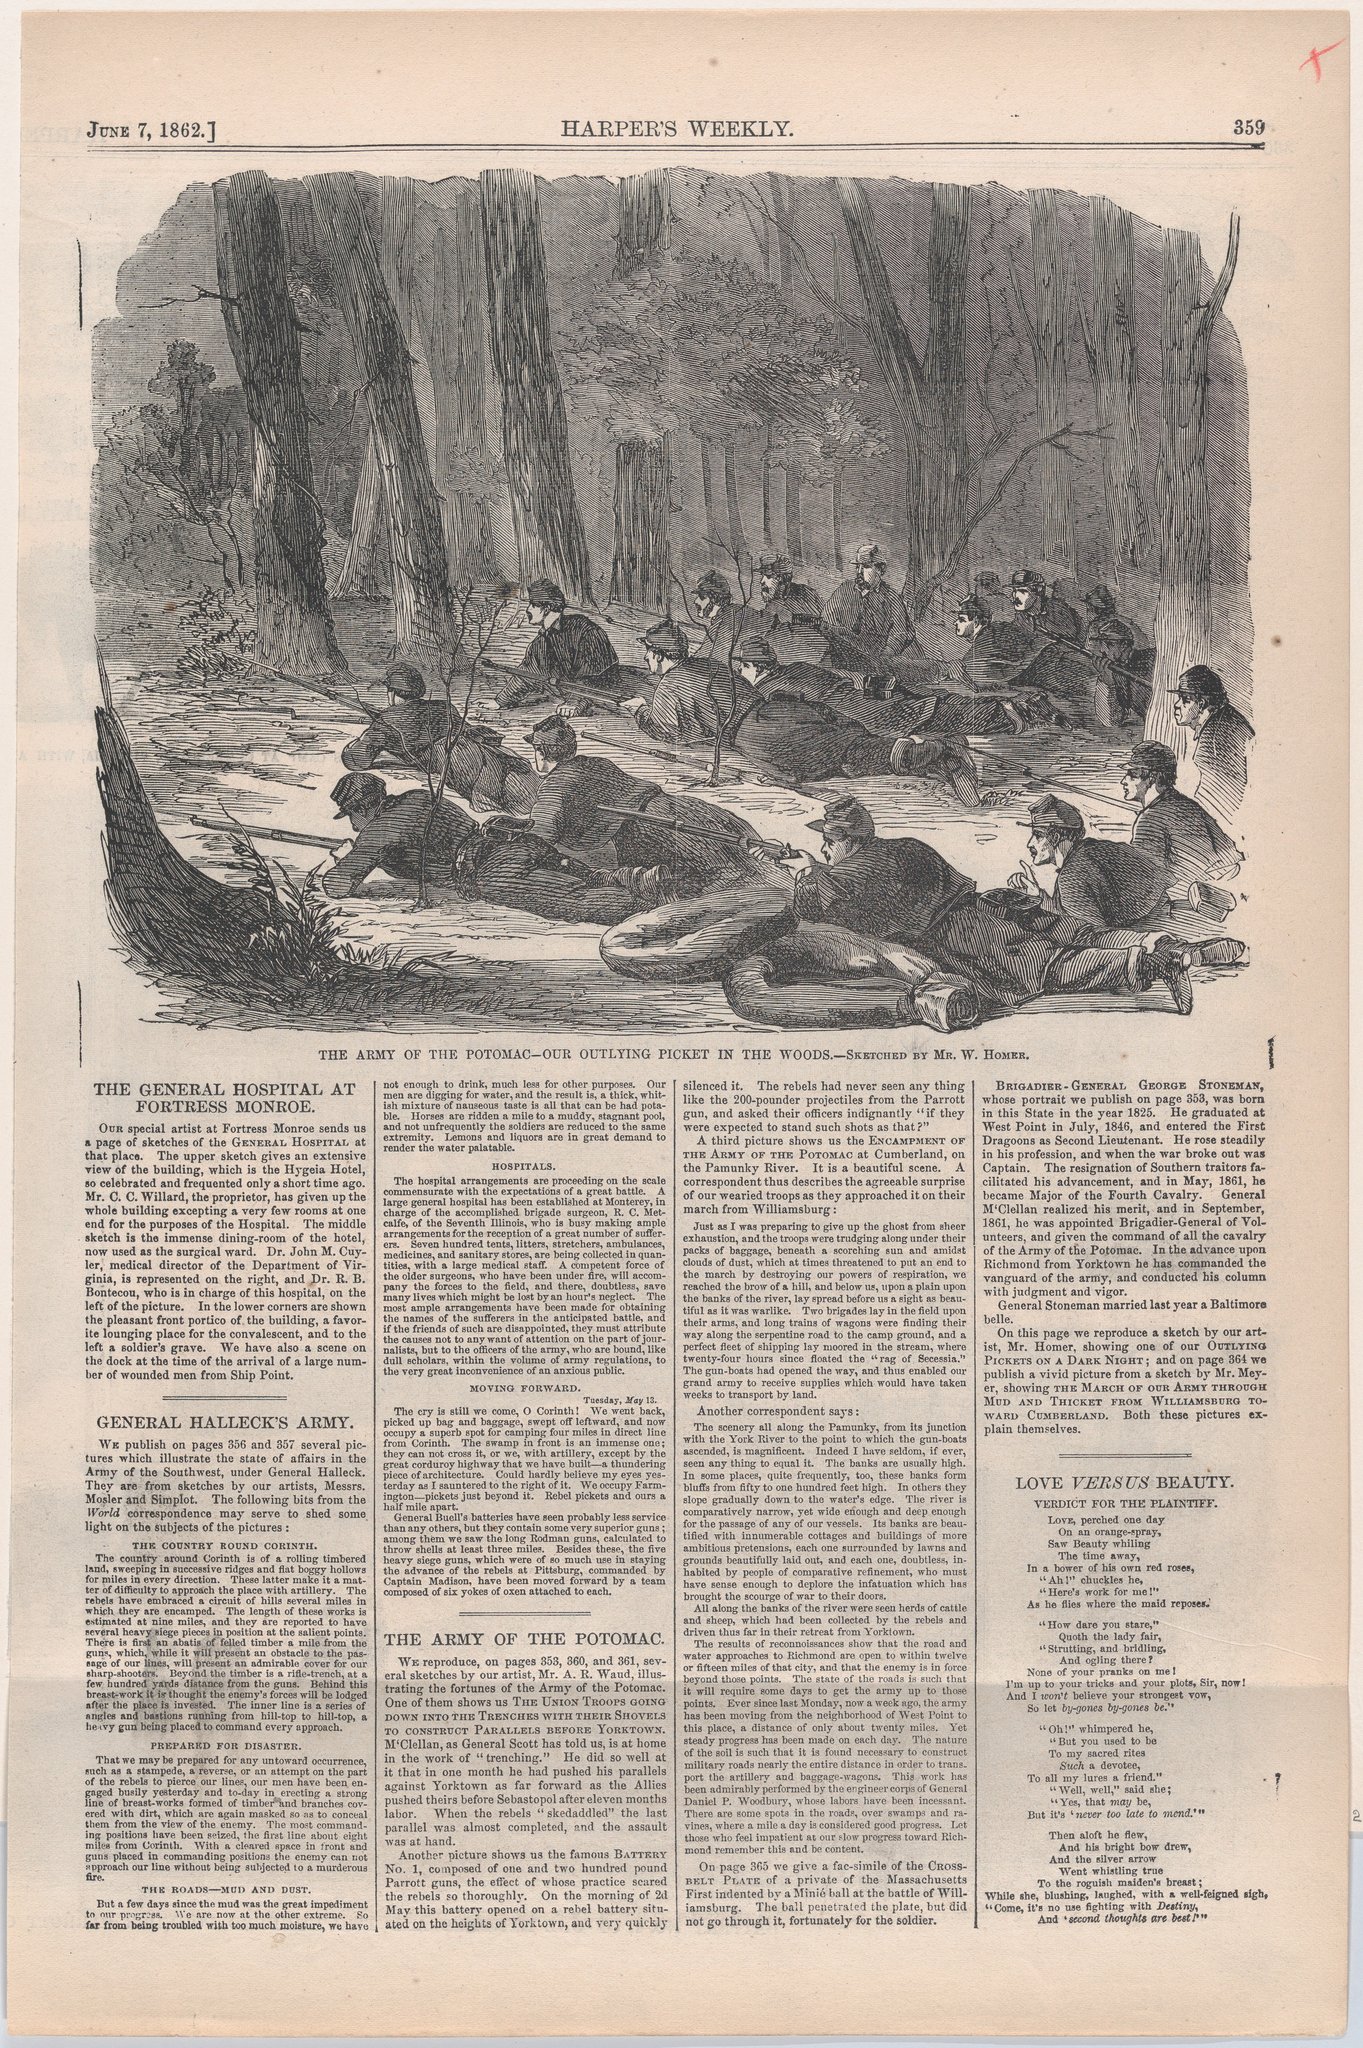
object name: print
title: The Army of the Potomac – Our Outlying Picket in the Woods (from "Harper's Weekly," Vol. VI)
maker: winslow homer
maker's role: artist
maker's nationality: american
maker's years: 1836-1910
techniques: engraving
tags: army,soldiers,american civil war,men